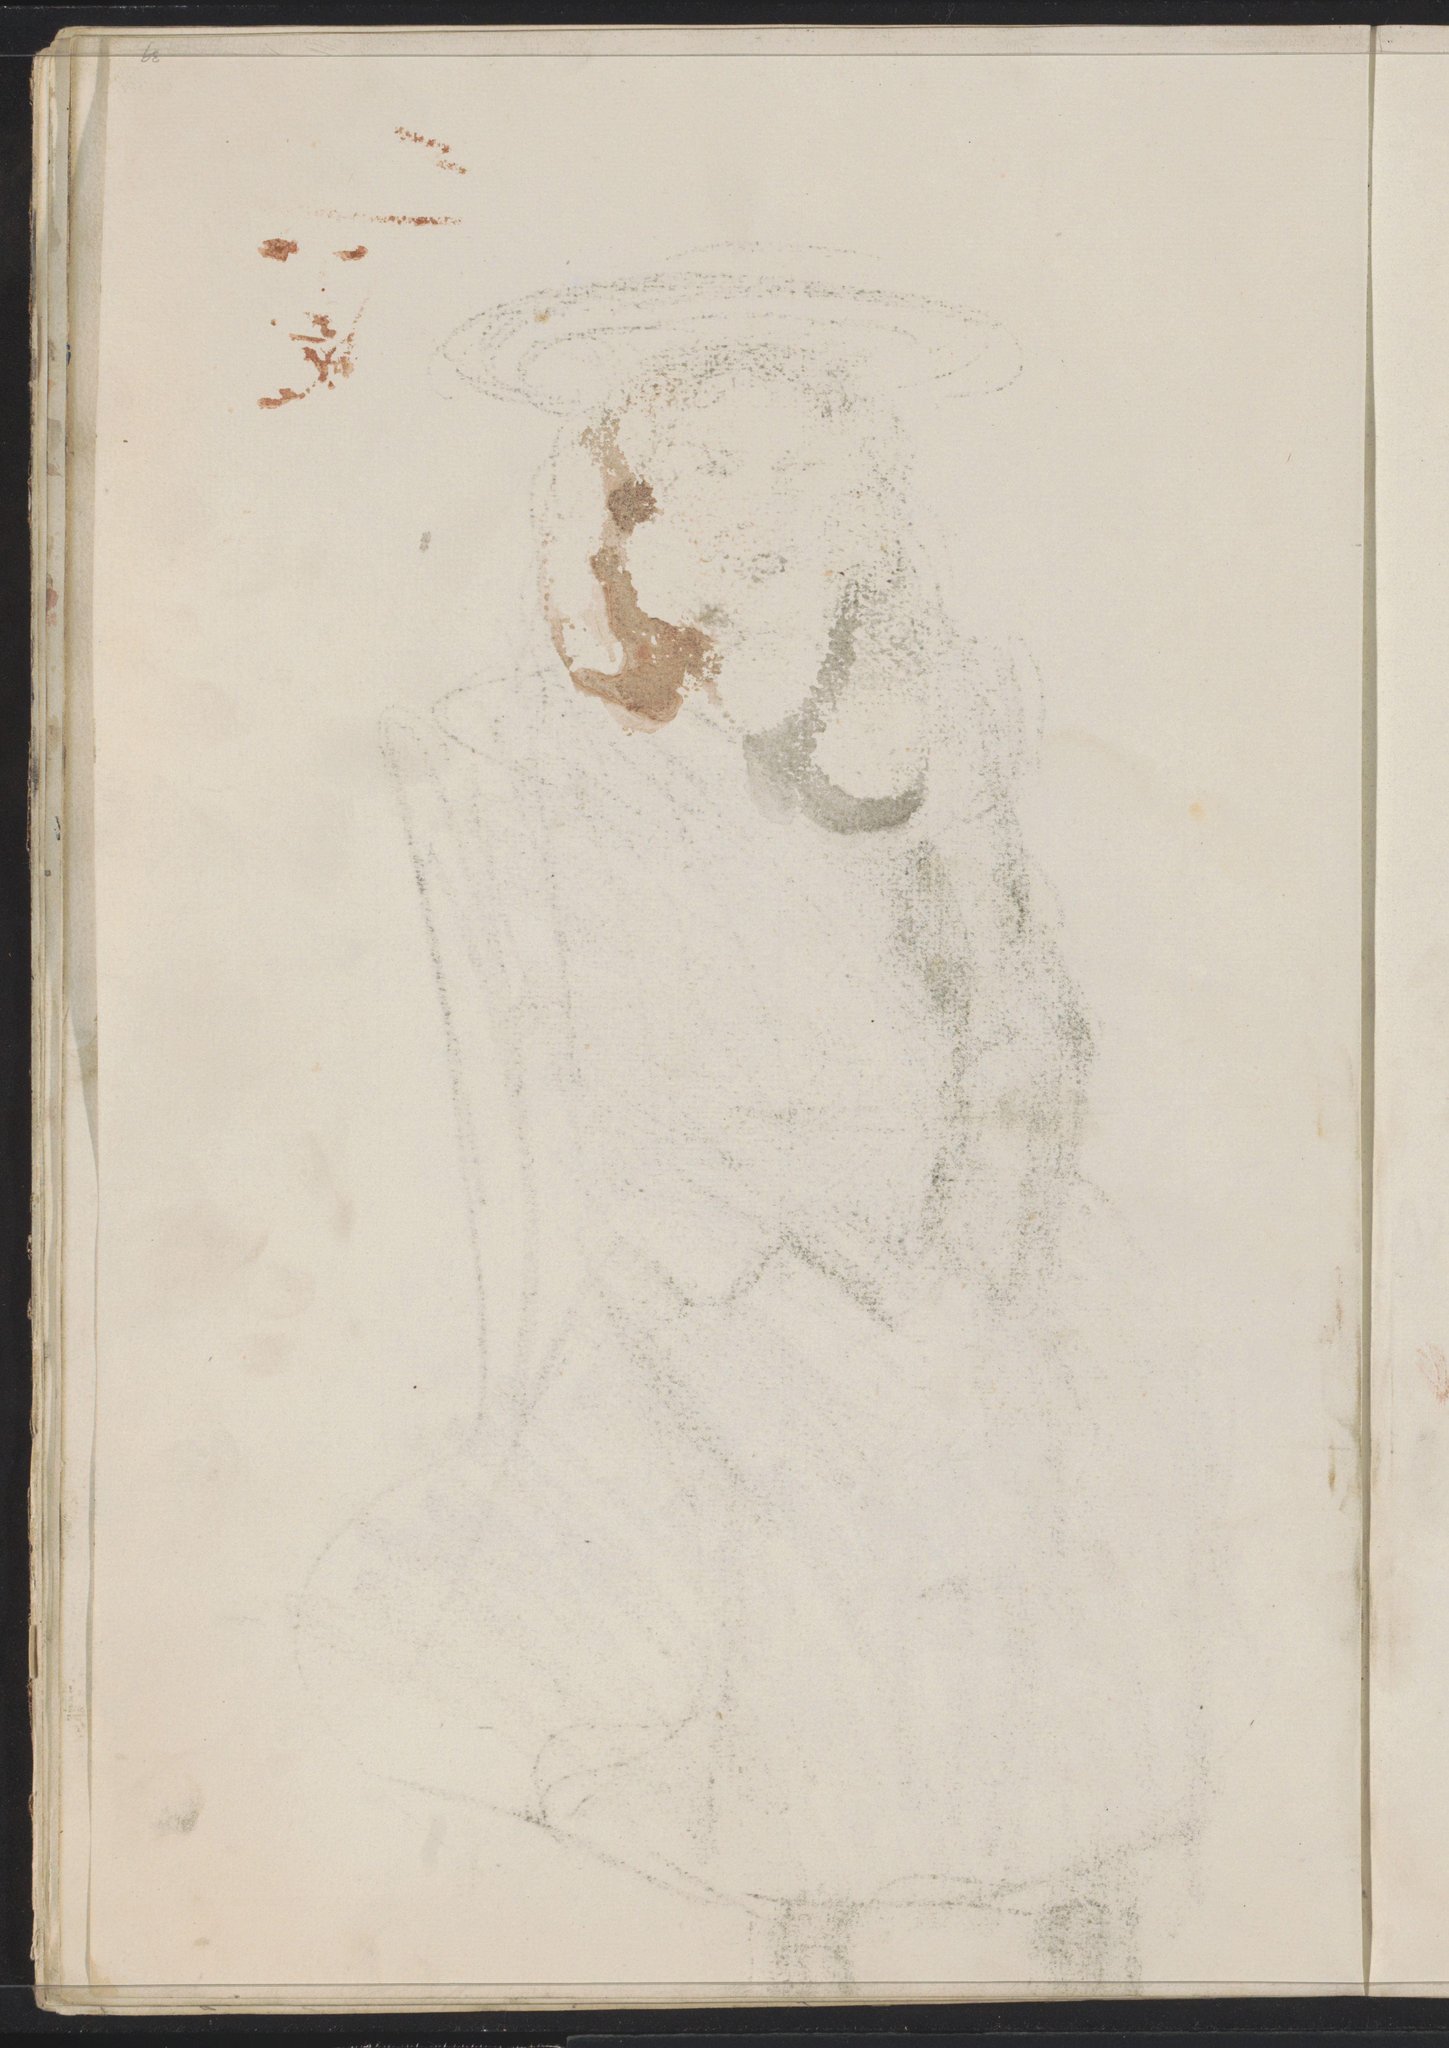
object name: sketchbook leaf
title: Abklatsch van de tekening op blad 13 recto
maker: isaac israels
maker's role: draughtsman, painter, print maker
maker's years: 1865-1934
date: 1875-1934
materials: paper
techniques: printmaking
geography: the hague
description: Blad 12 verso uit schetsboek LXIX met 25 bladen.